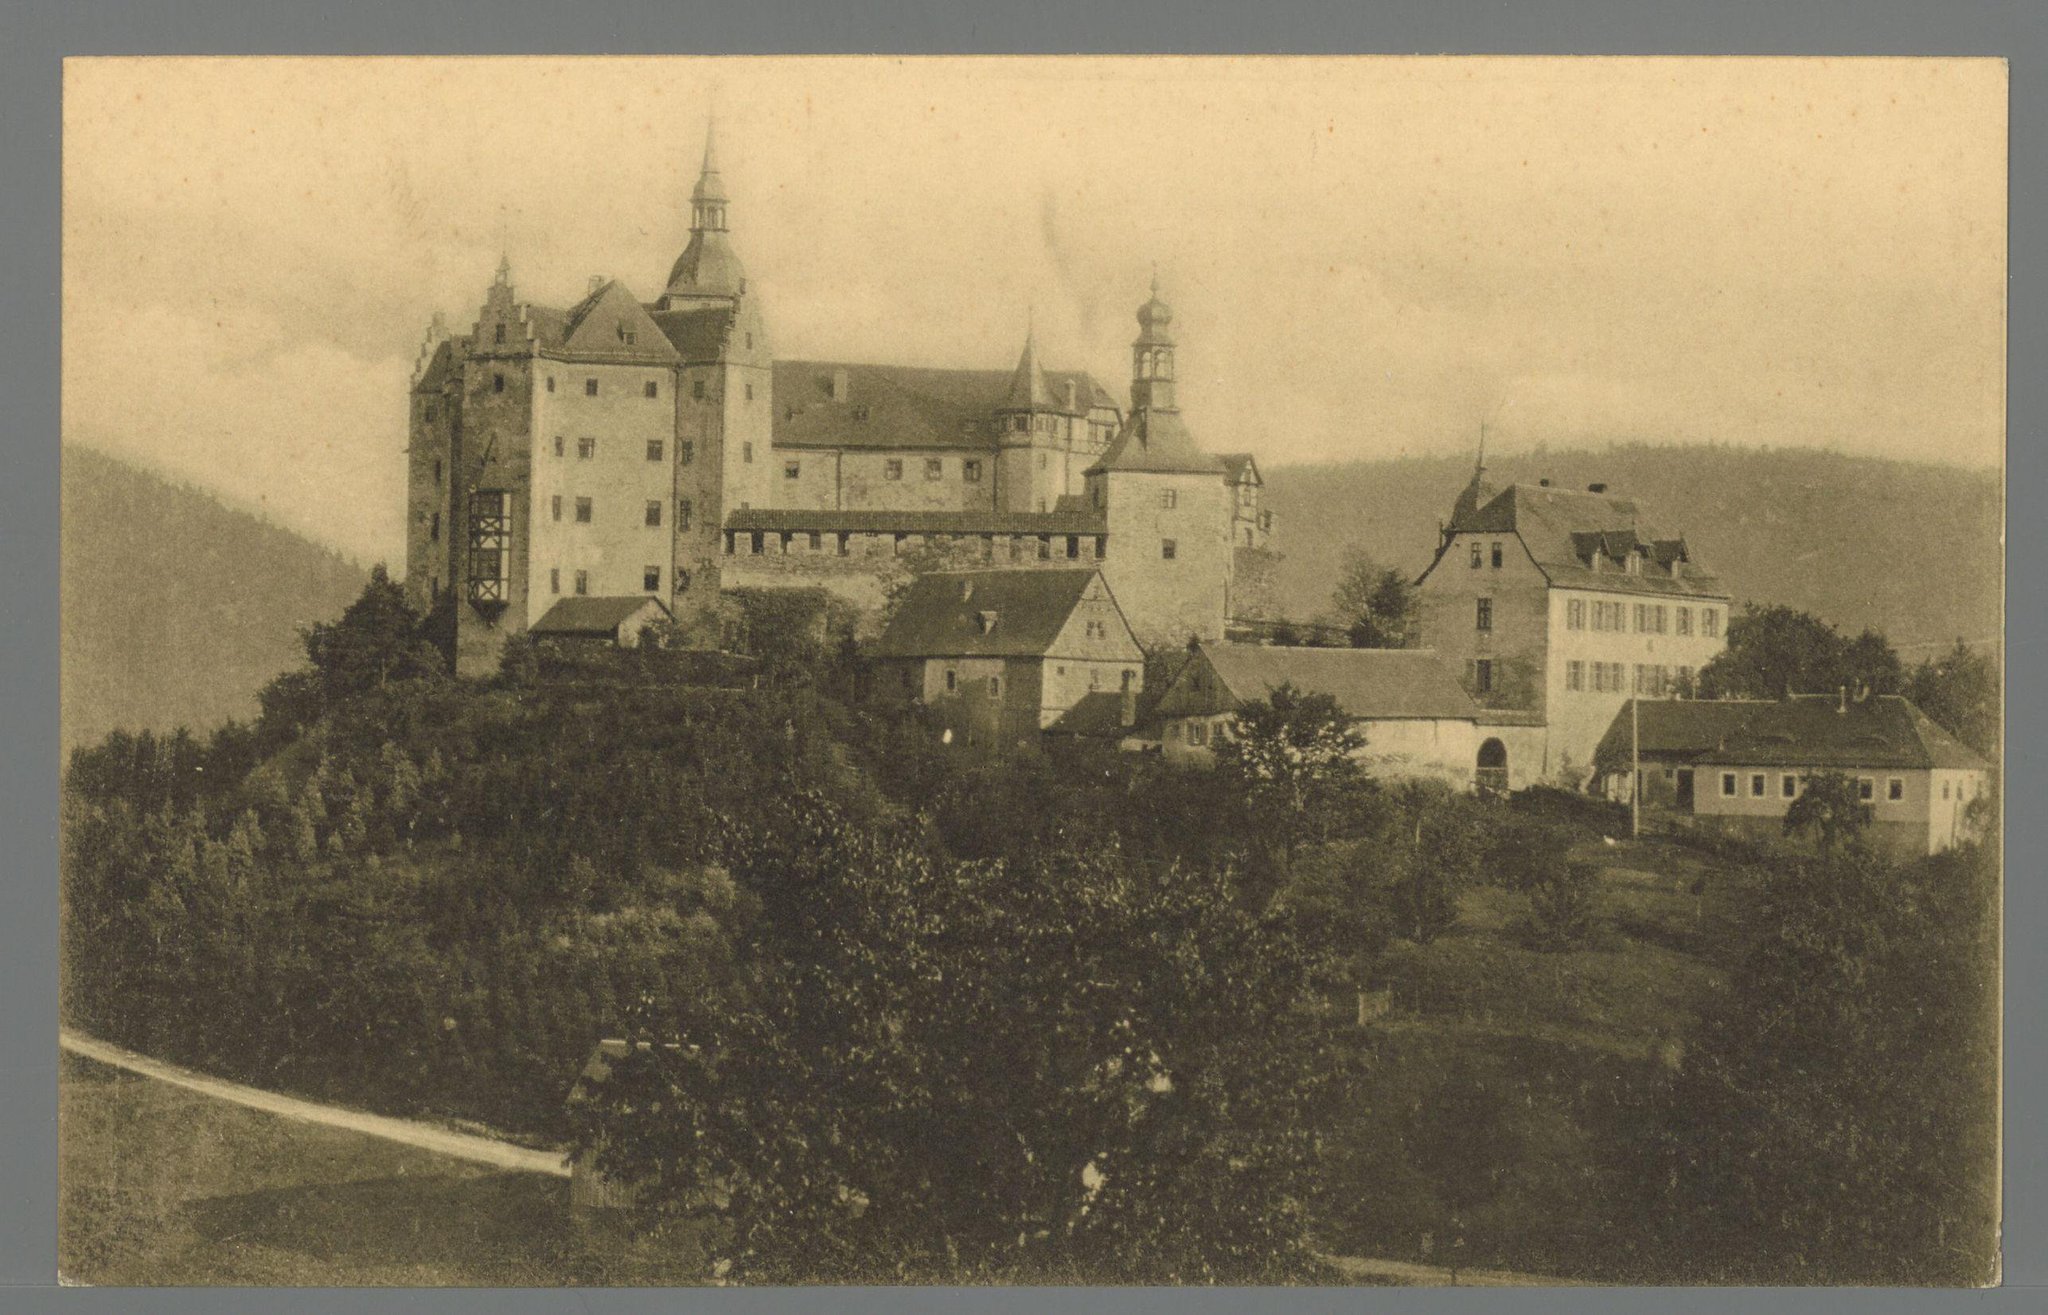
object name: ansichtkaart, prentbriefkaart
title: Burg Lauenstein. Thüringisch-fränkische Grenzwarte gegen Norden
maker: Anonymous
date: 1905-1930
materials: cardboard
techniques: photograph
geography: ludwigsstadt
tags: castle